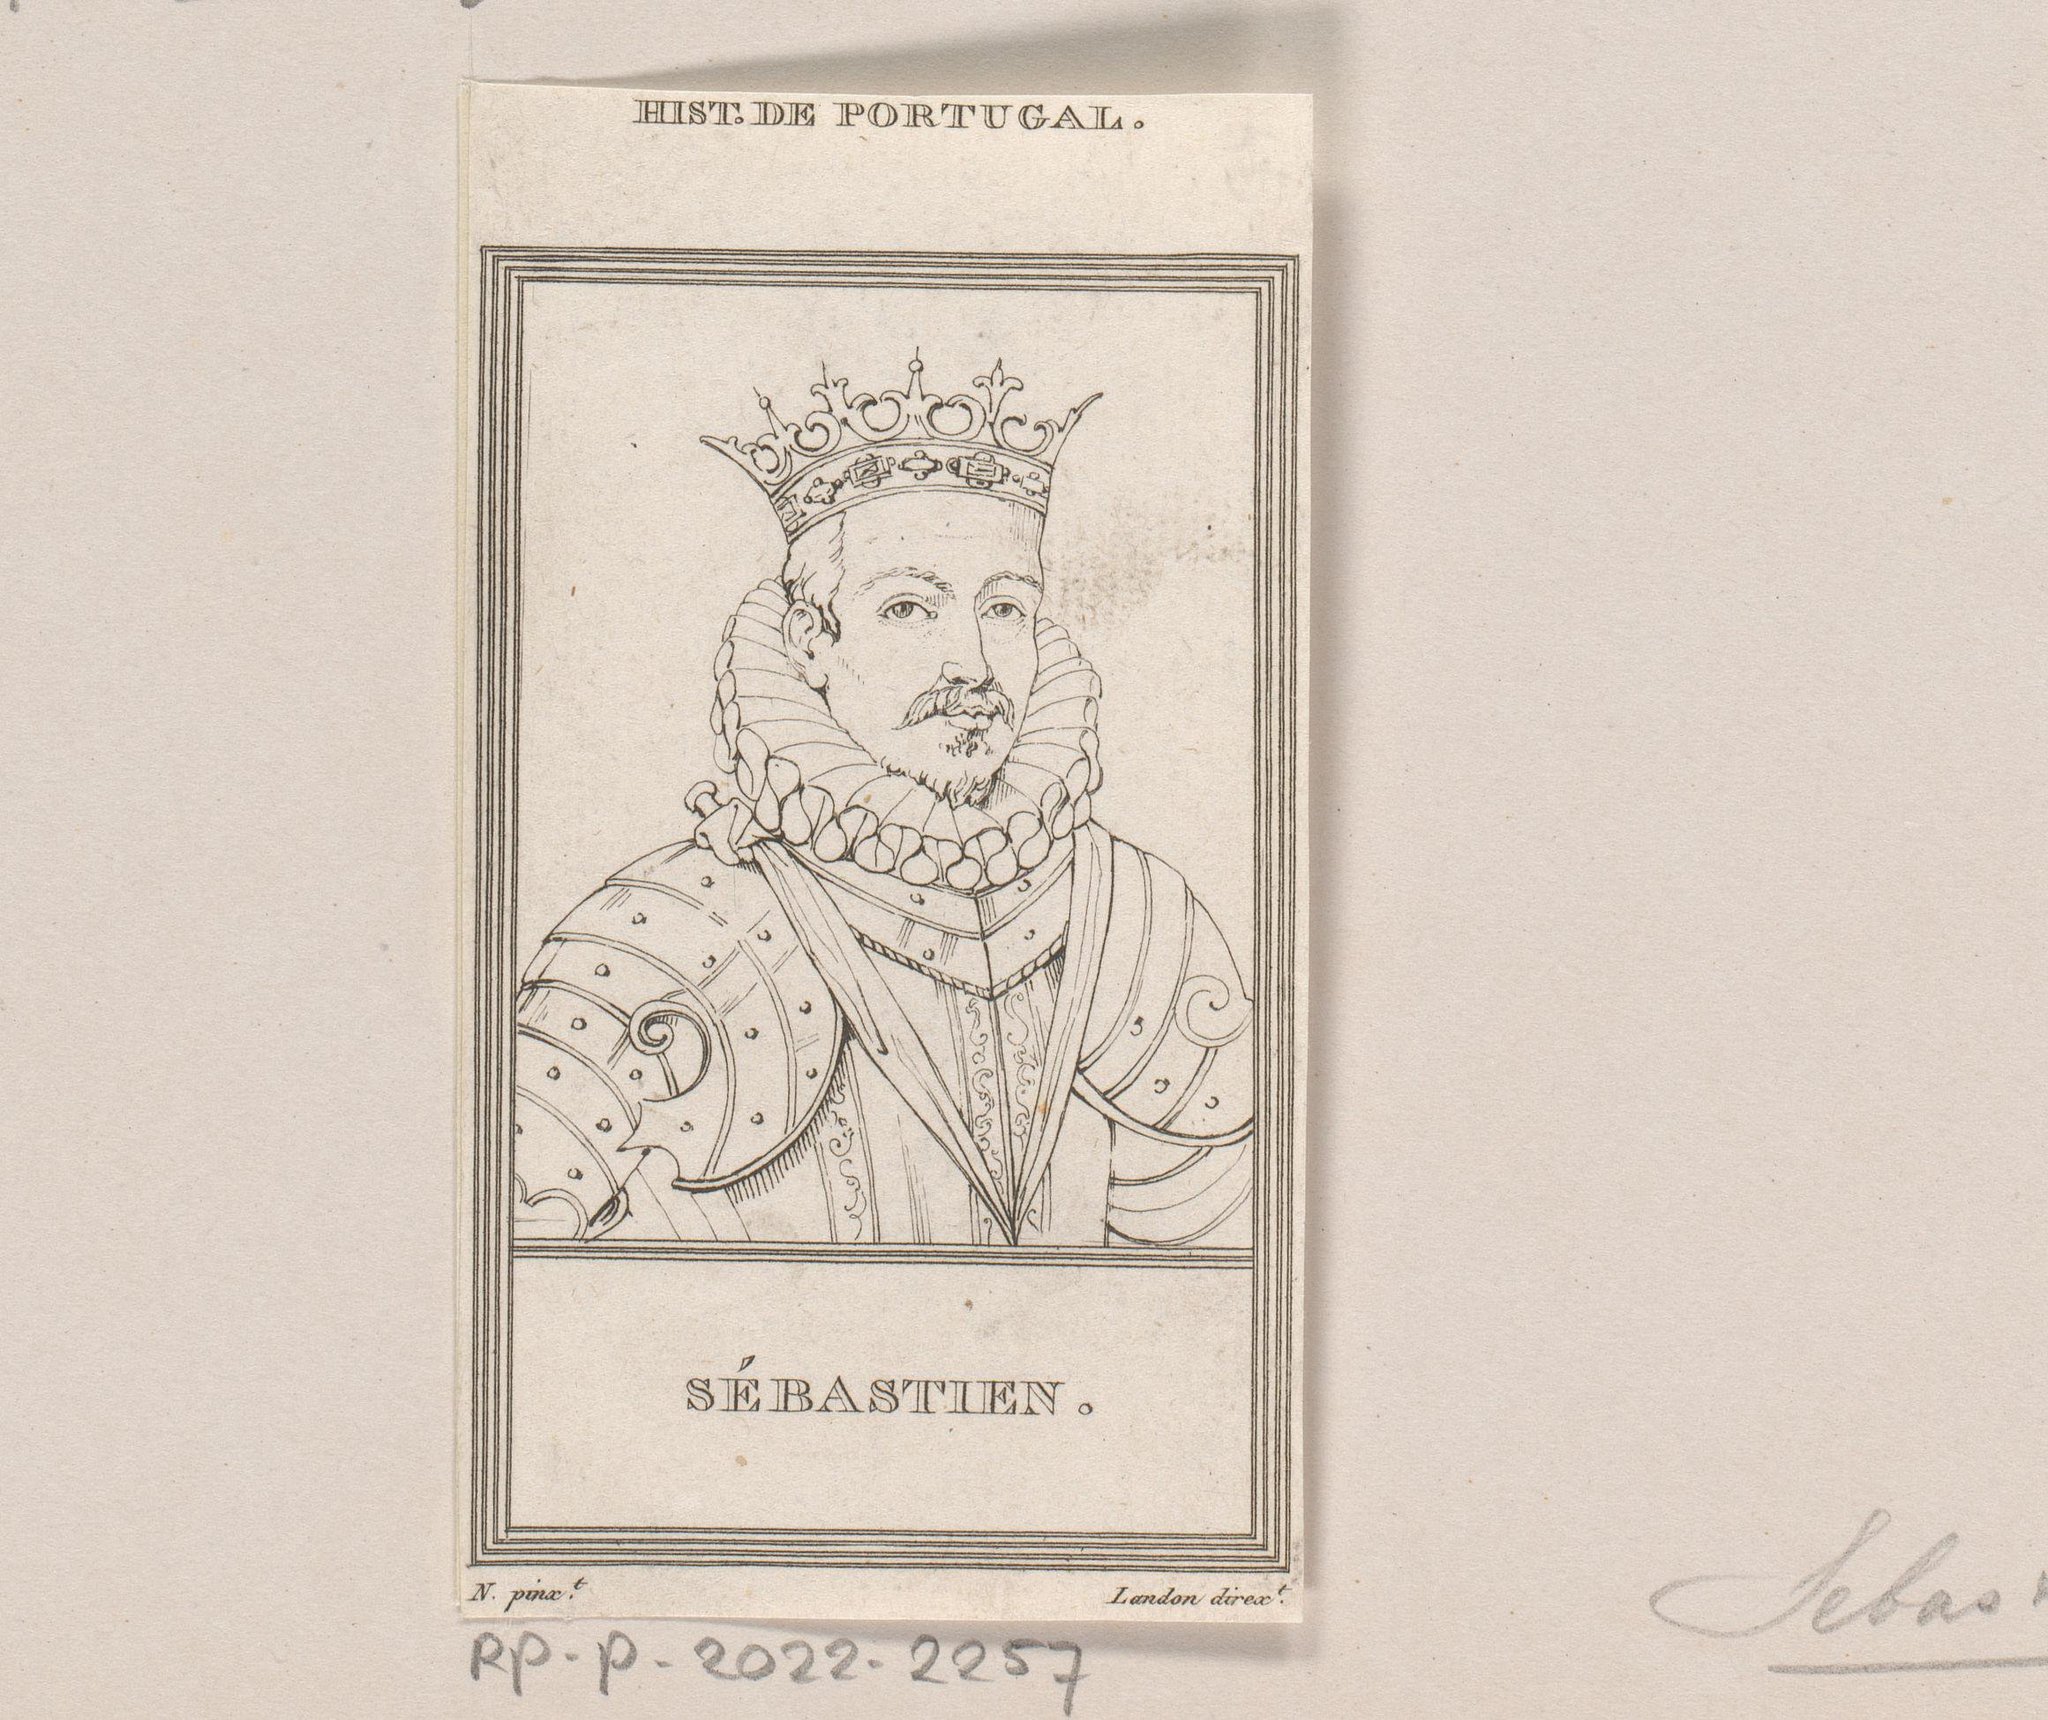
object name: print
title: Portret van Sebastiaan I van Portugal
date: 1808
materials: paper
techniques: etching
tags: historical persons, king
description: Prent waarschijnlijk uit: Landon, Charles Paul. Galerie historique des hommes les plus célèbres (...). Parijs: Imprimerie des Annales du Musée, 1808, dl. 11.